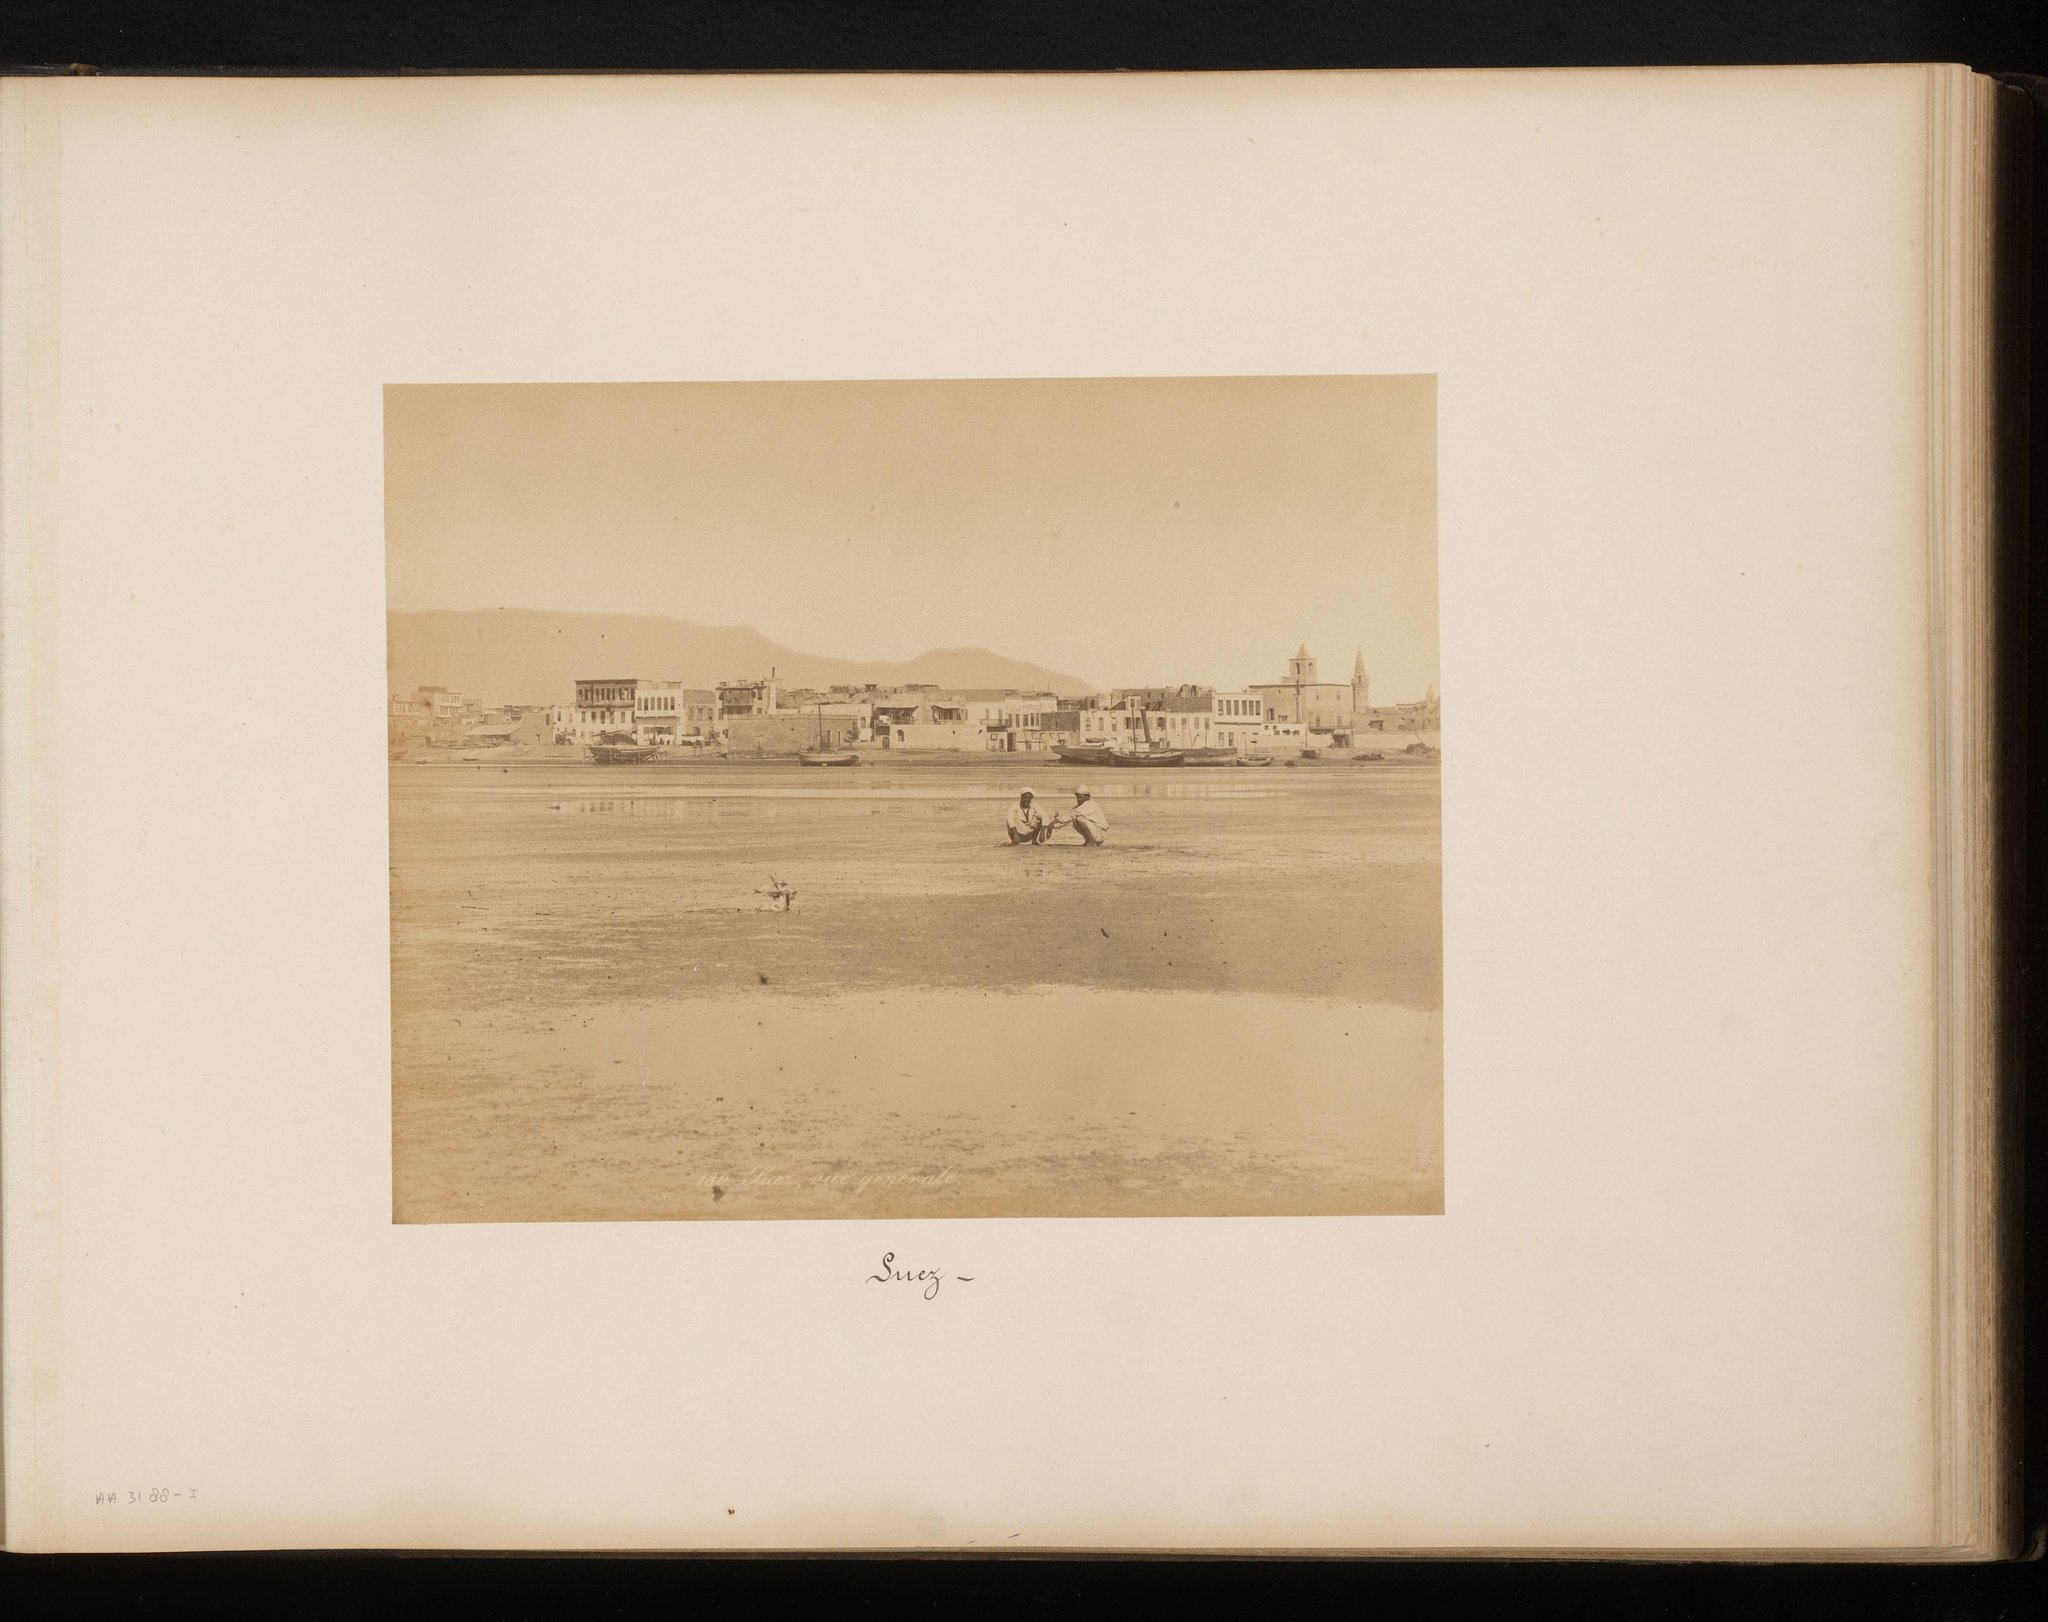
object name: photograph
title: Gezicht op Suez met op de voorgrond twee hurkende mannen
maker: Anonymous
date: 1880-1883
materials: photographic support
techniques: albumen print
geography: suez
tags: prospect of village, silhouette of village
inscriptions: number: ‘180’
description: Onderdeel van Reisalbum met opnames van bezienswaardigheden in Egypte, Nederlands-Indië, Singapore en Ceylon.